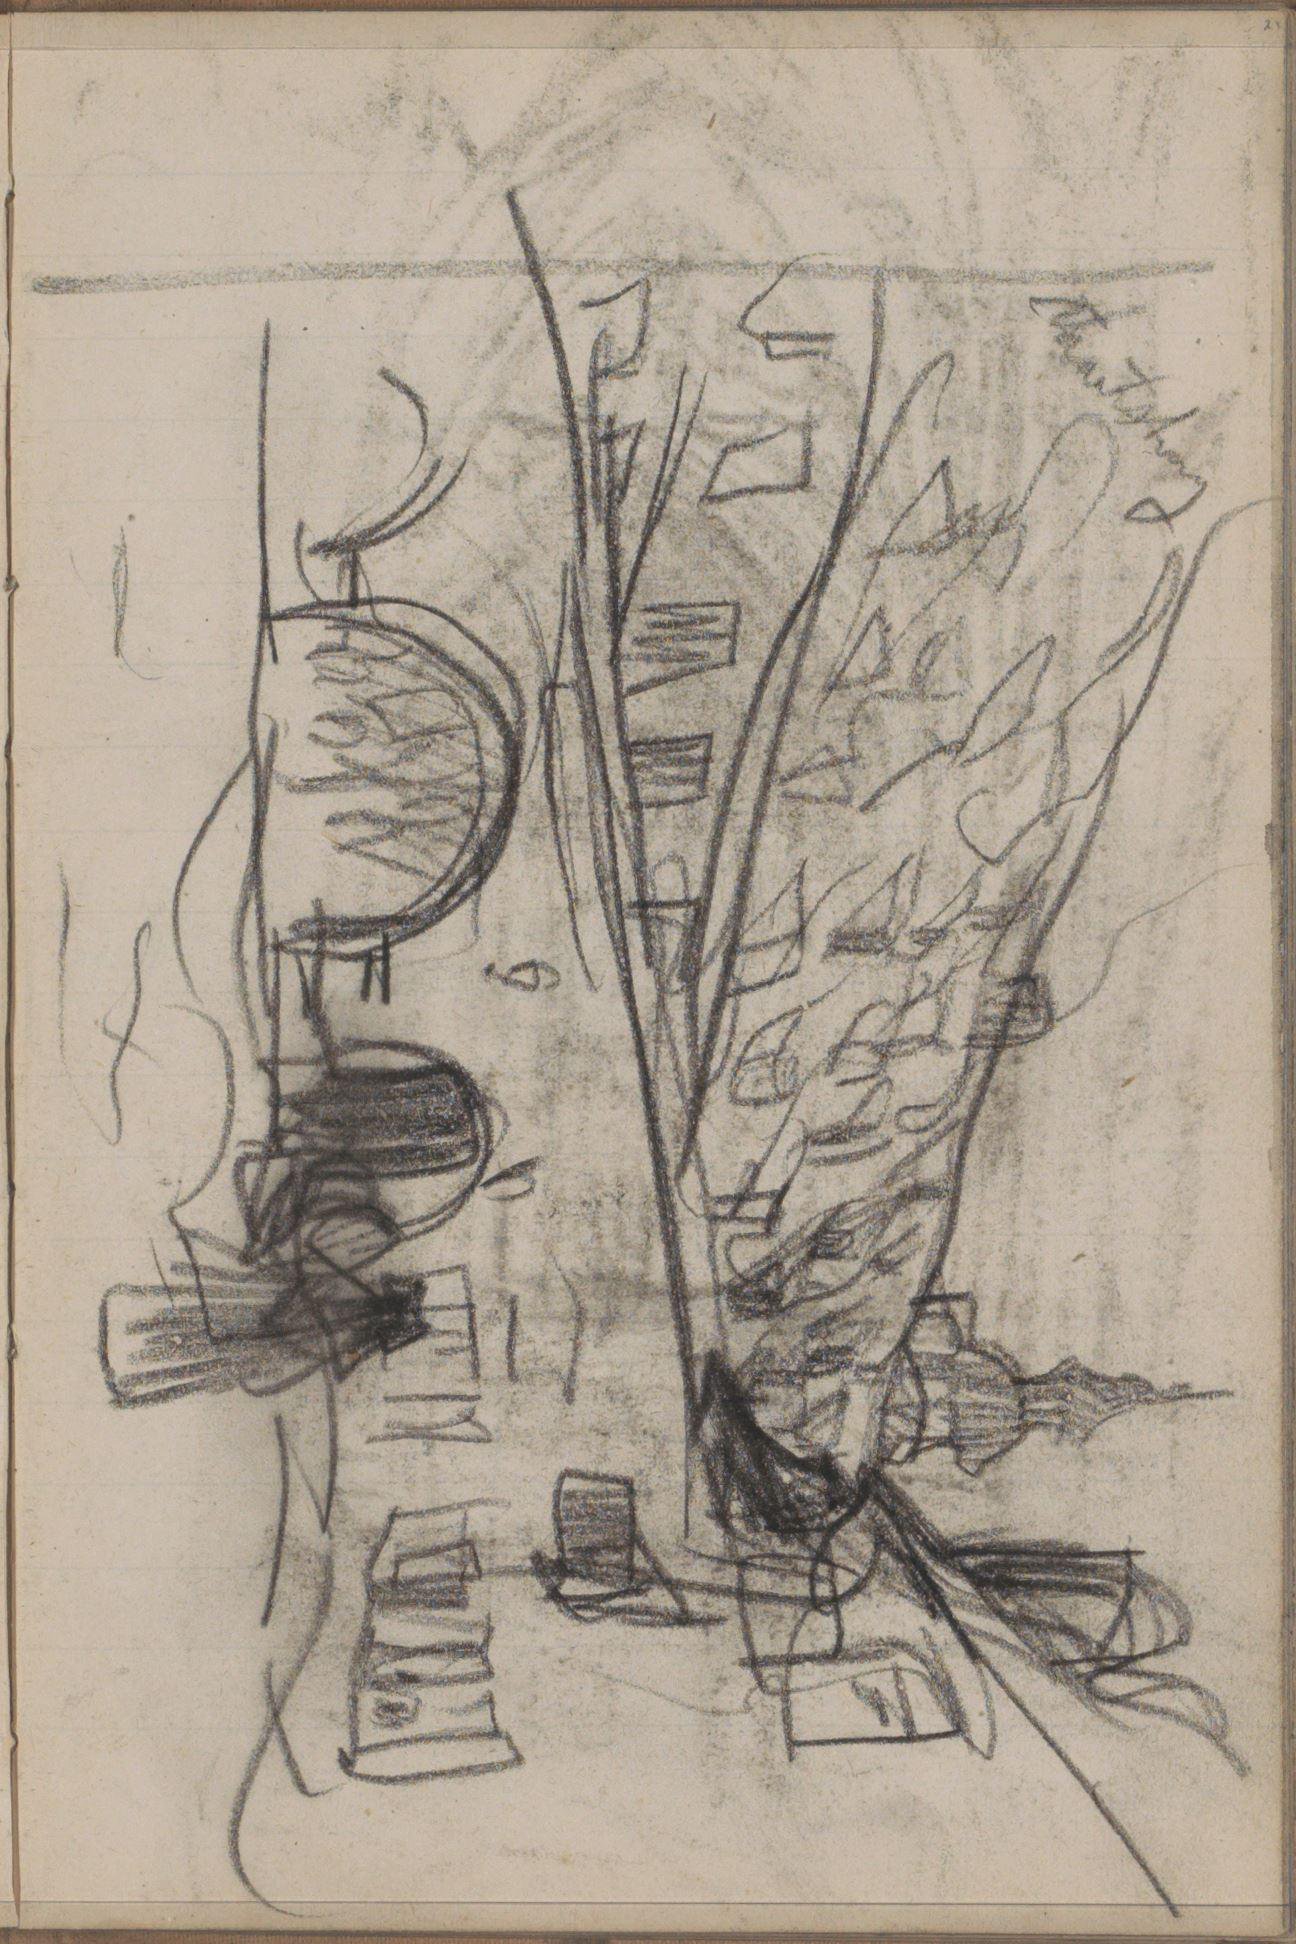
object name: sketchbook leaf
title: Straat met torenspits in Straatsburg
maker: marius bauer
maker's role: draughtsman, print maker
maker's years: 1867-1932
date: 1888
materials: chalk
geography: straatsburg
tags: spire (of tower on house or building), street (+ city(-scape) with figures, staffage)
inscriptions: annotation: ‘straatsburg’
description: Op de voorgrond een galerij met bogen. Pagina 21 uit een schetsboek met 49 bladen.